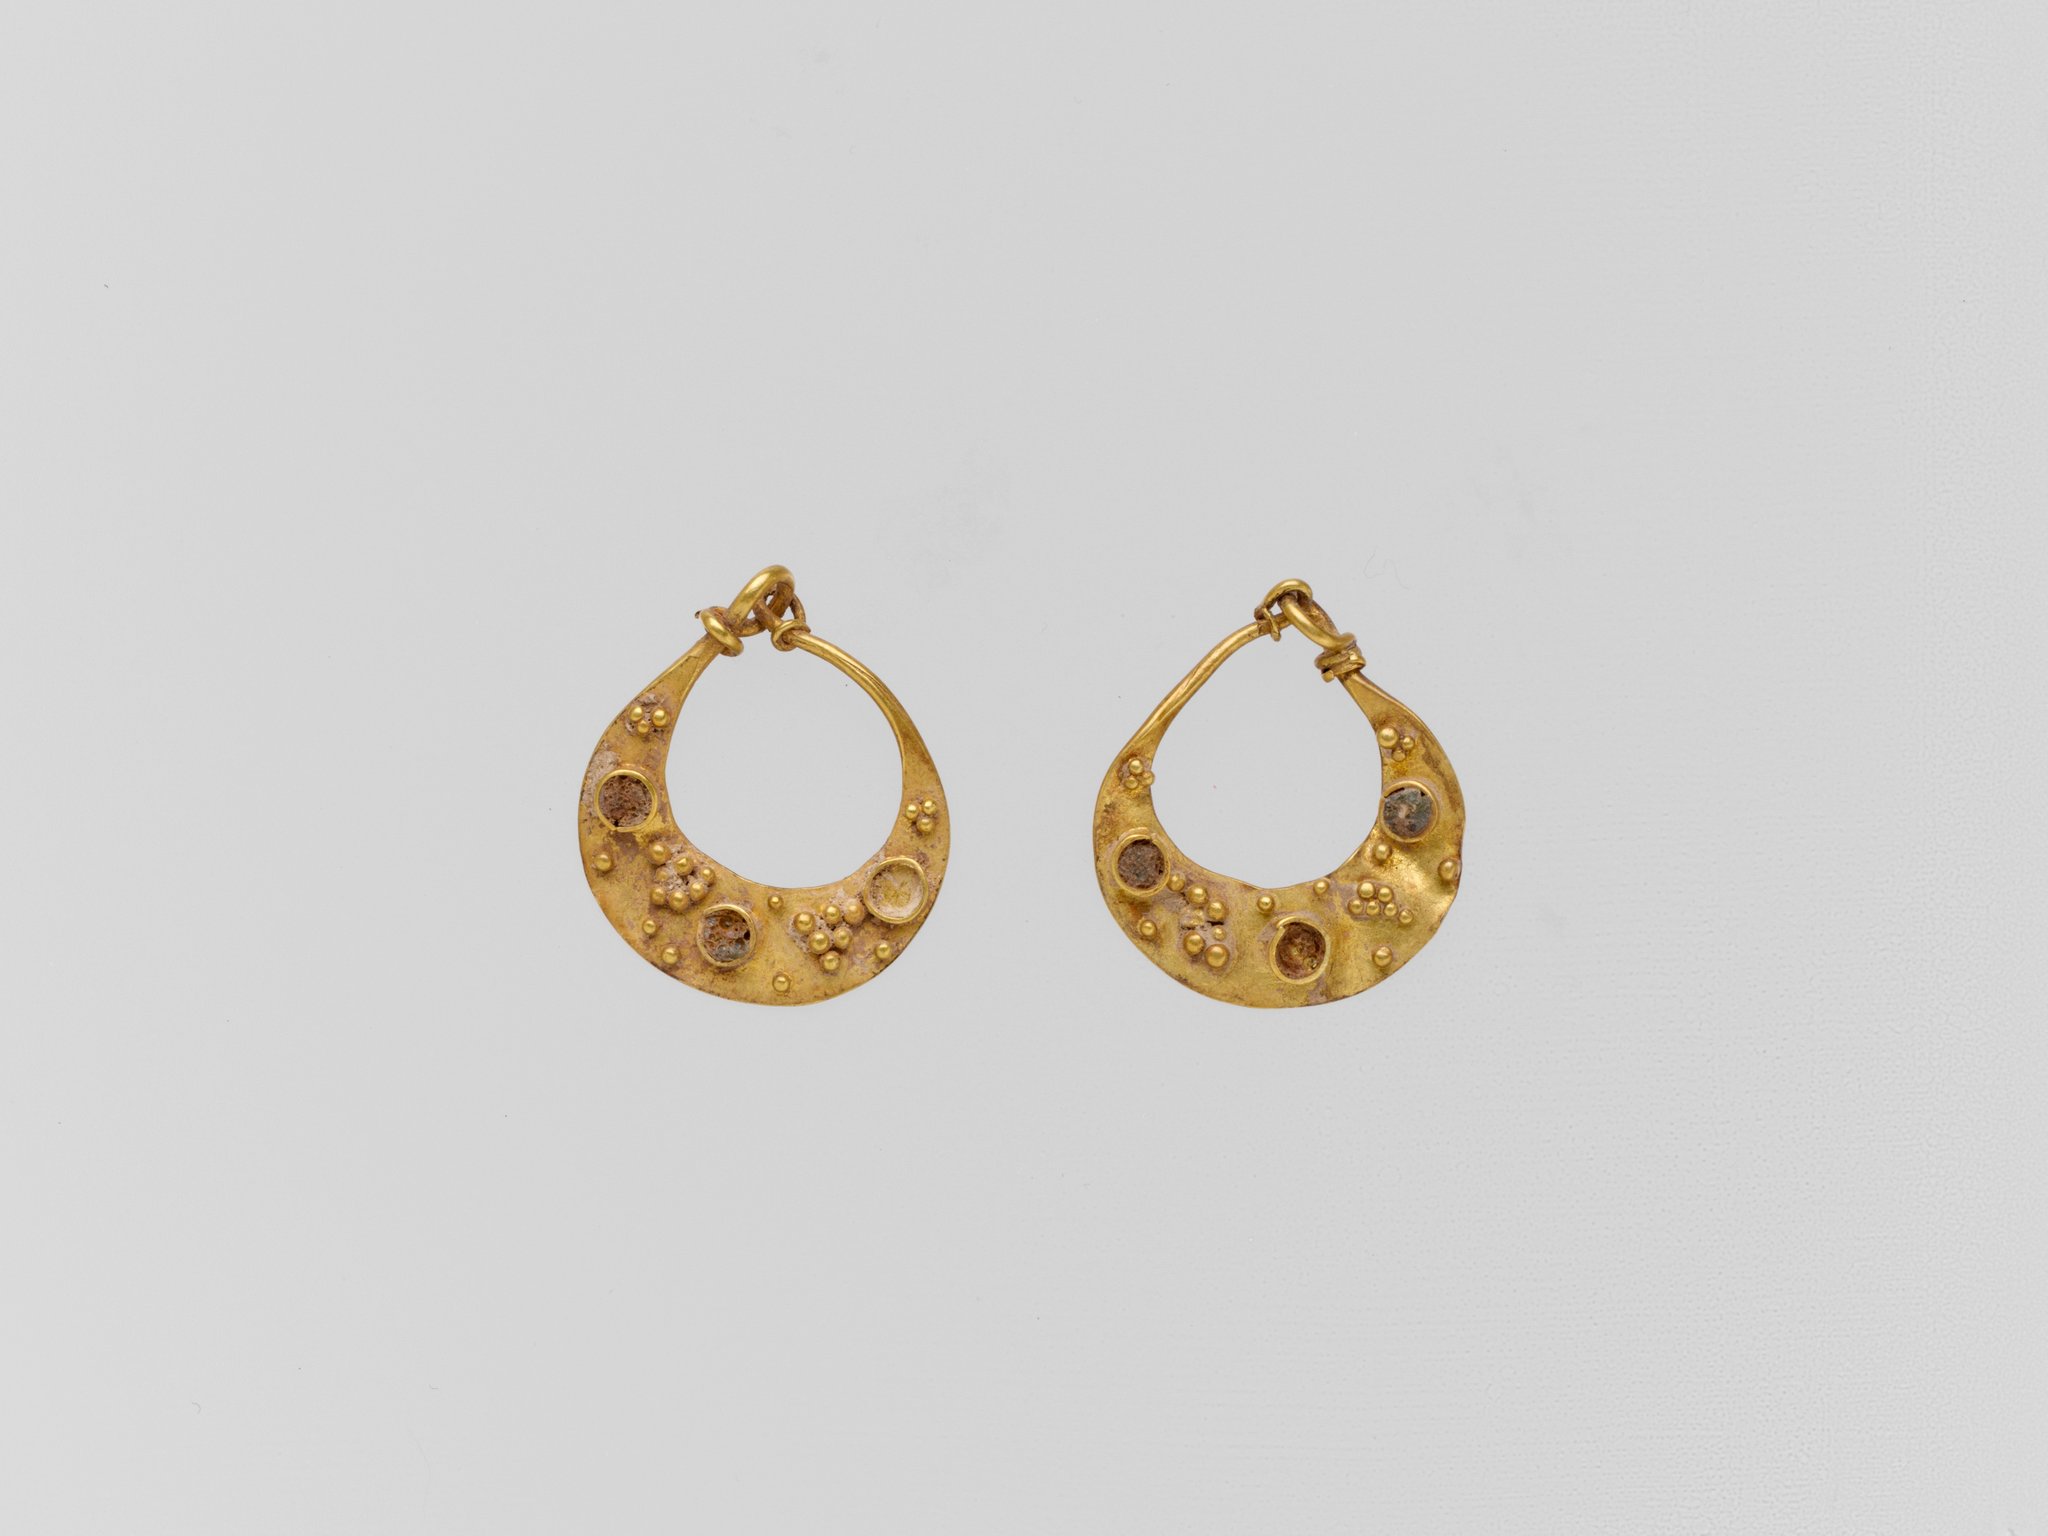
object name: earring, crescent shaped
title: Gold crescent-shaped earring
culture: cypriot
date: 500 BCE-100 CE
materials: gold